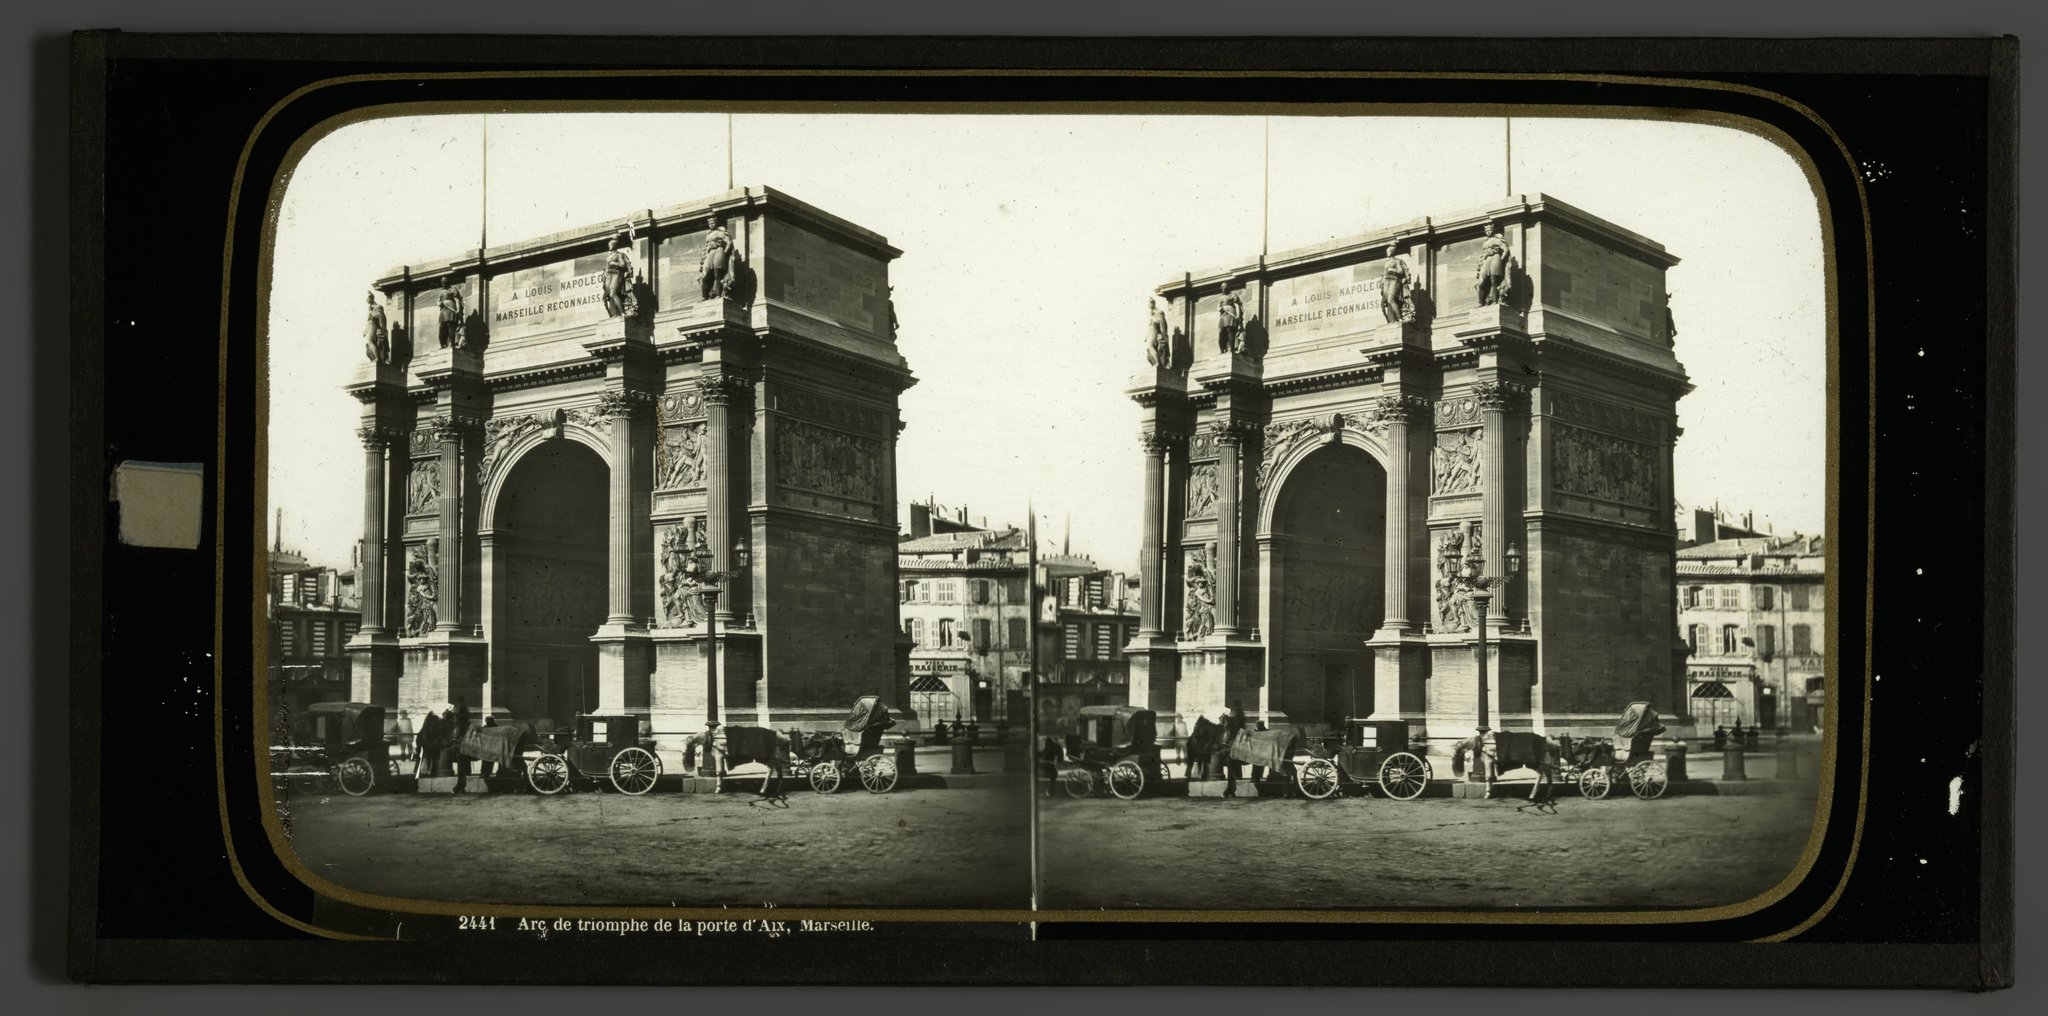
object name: stereoscopic photograph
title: Gezicht op de Porte d'Aix in Marseille, Frankrijk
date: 1860-1870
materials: glass, paper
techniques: slide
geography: marseille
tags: triumphal arch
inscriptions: number: ‘2441’